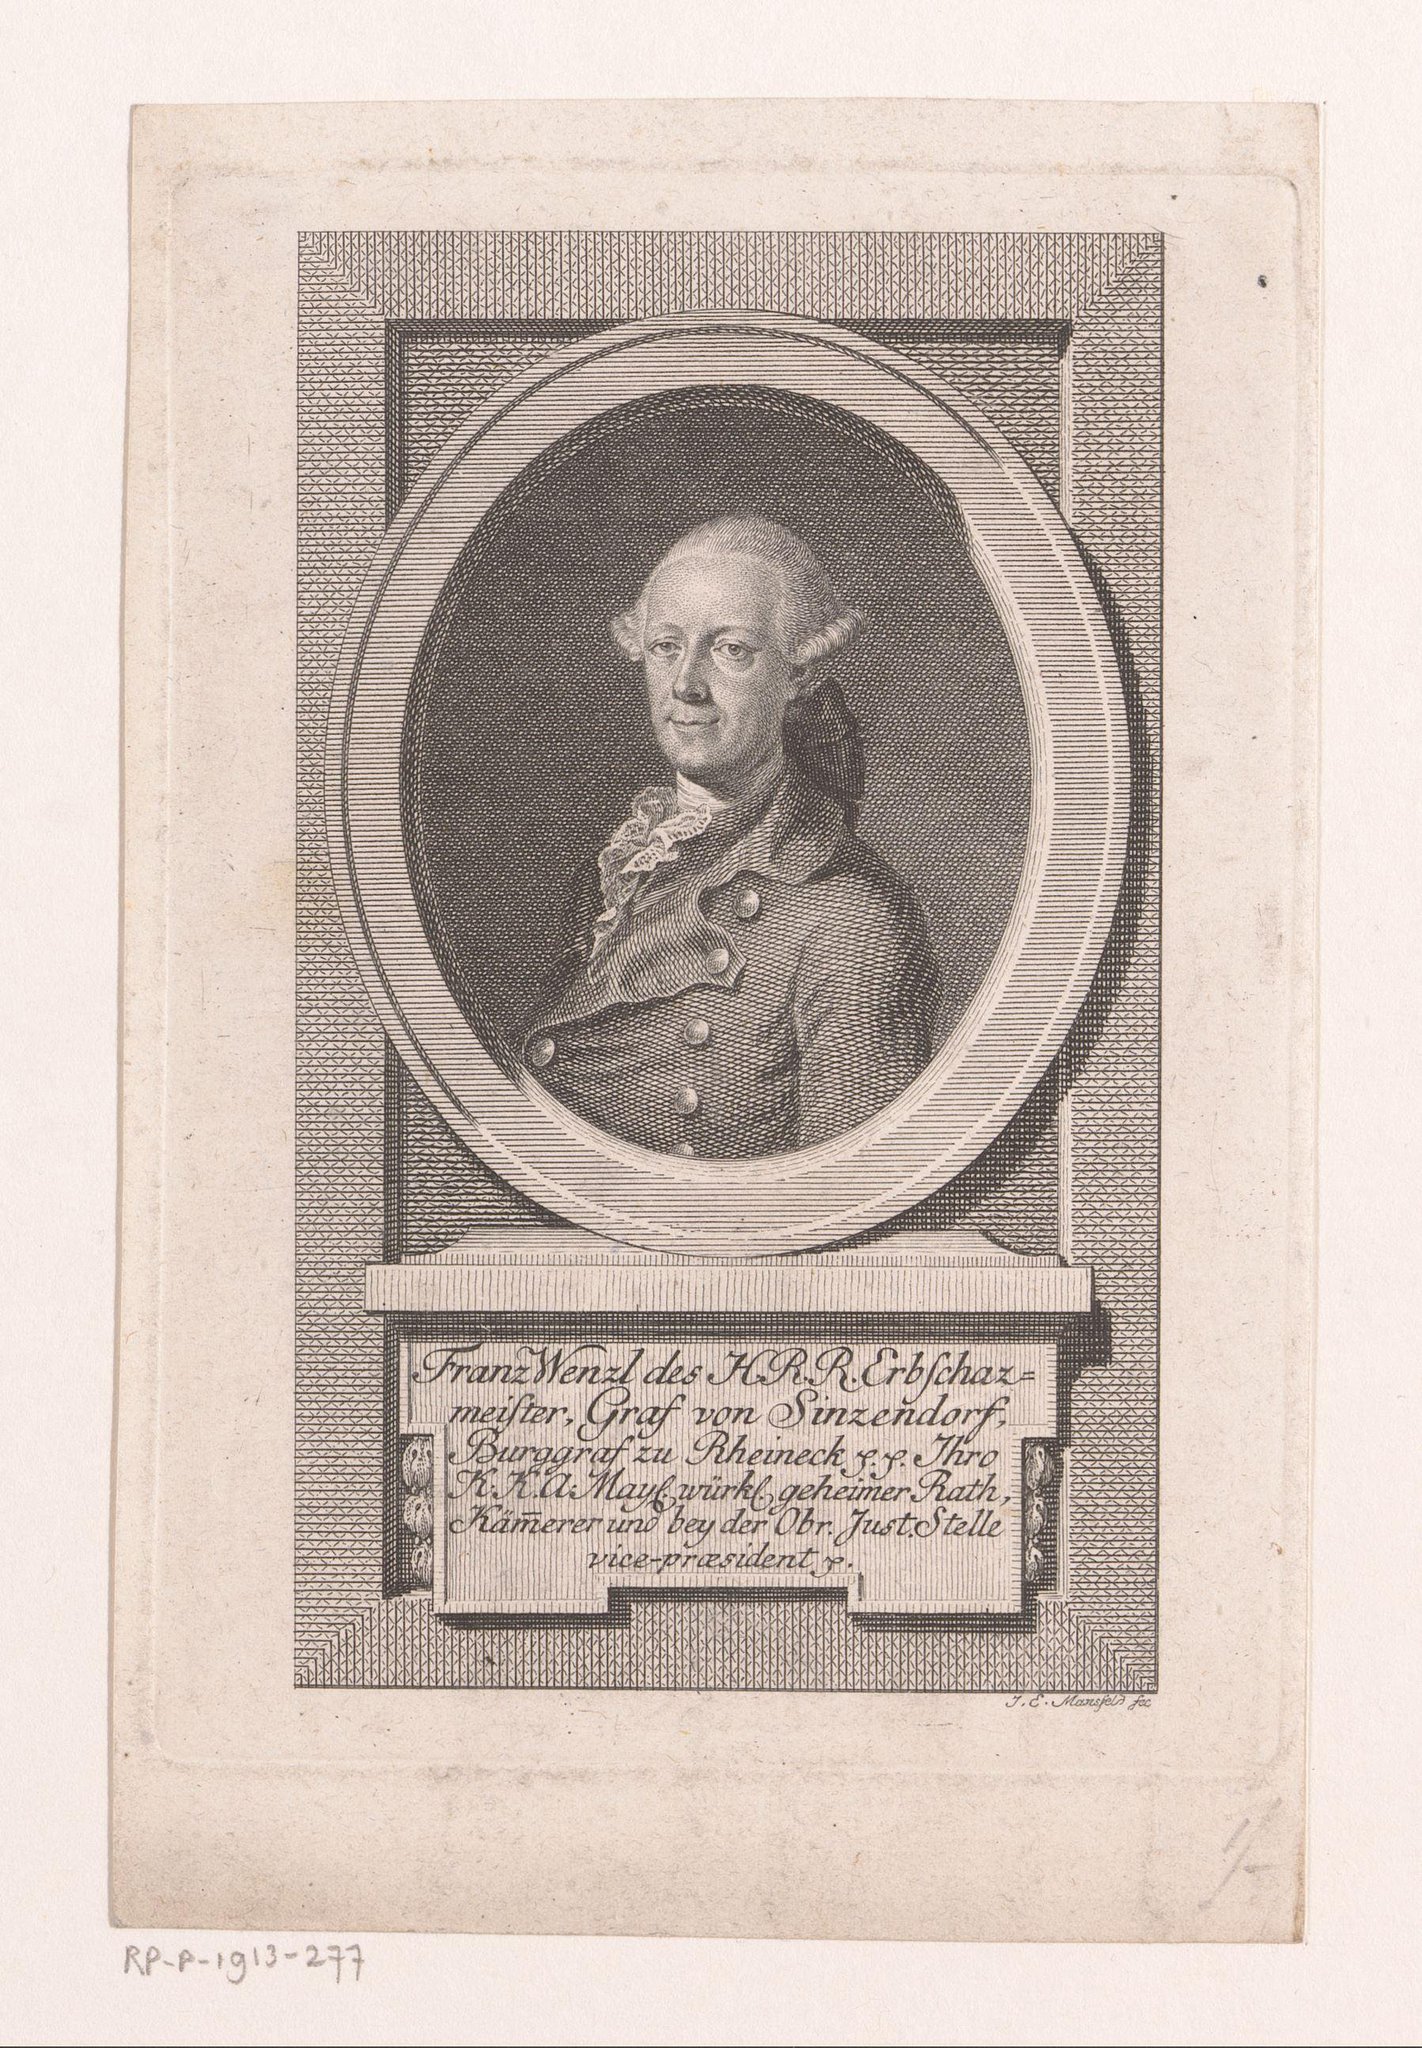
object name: print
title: Portret van Franz Wenzel von Sinzendorf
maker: johann ernst mansfeld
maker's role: print maker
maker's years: 1739-1796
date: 1749-1796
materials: paper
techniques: engraving, etching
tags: historical persons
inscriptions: collector's mark: Lugt 2228